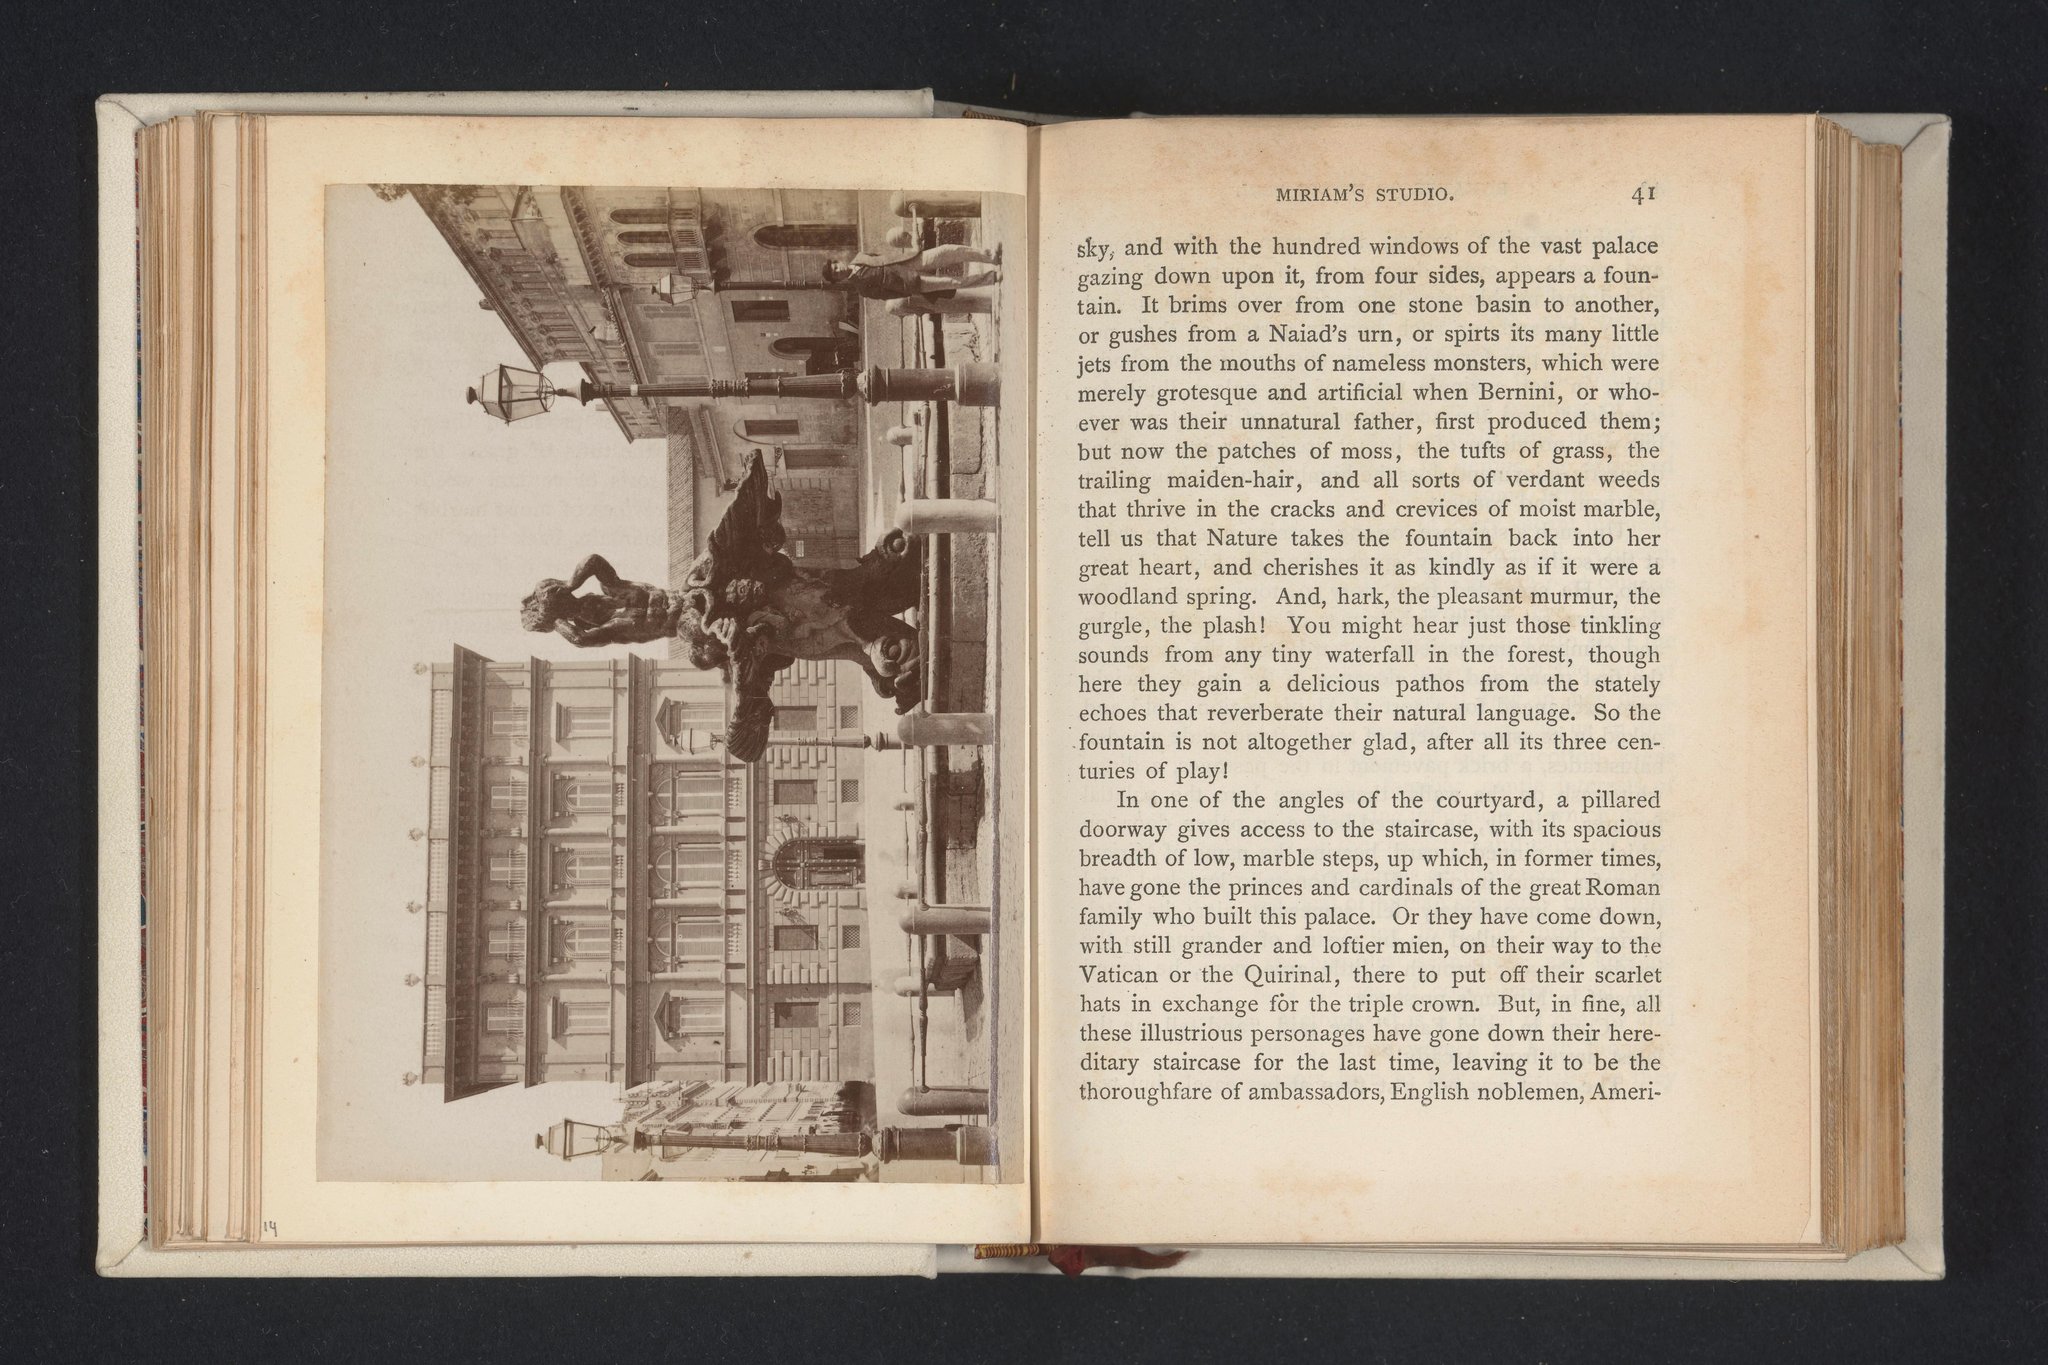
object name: page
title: Fontein op het Piazza Barberini in Rome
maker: Anonymous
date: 1850-1860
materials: photographic support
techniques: albumen print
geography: rome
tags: ornamental fountain, village square, place